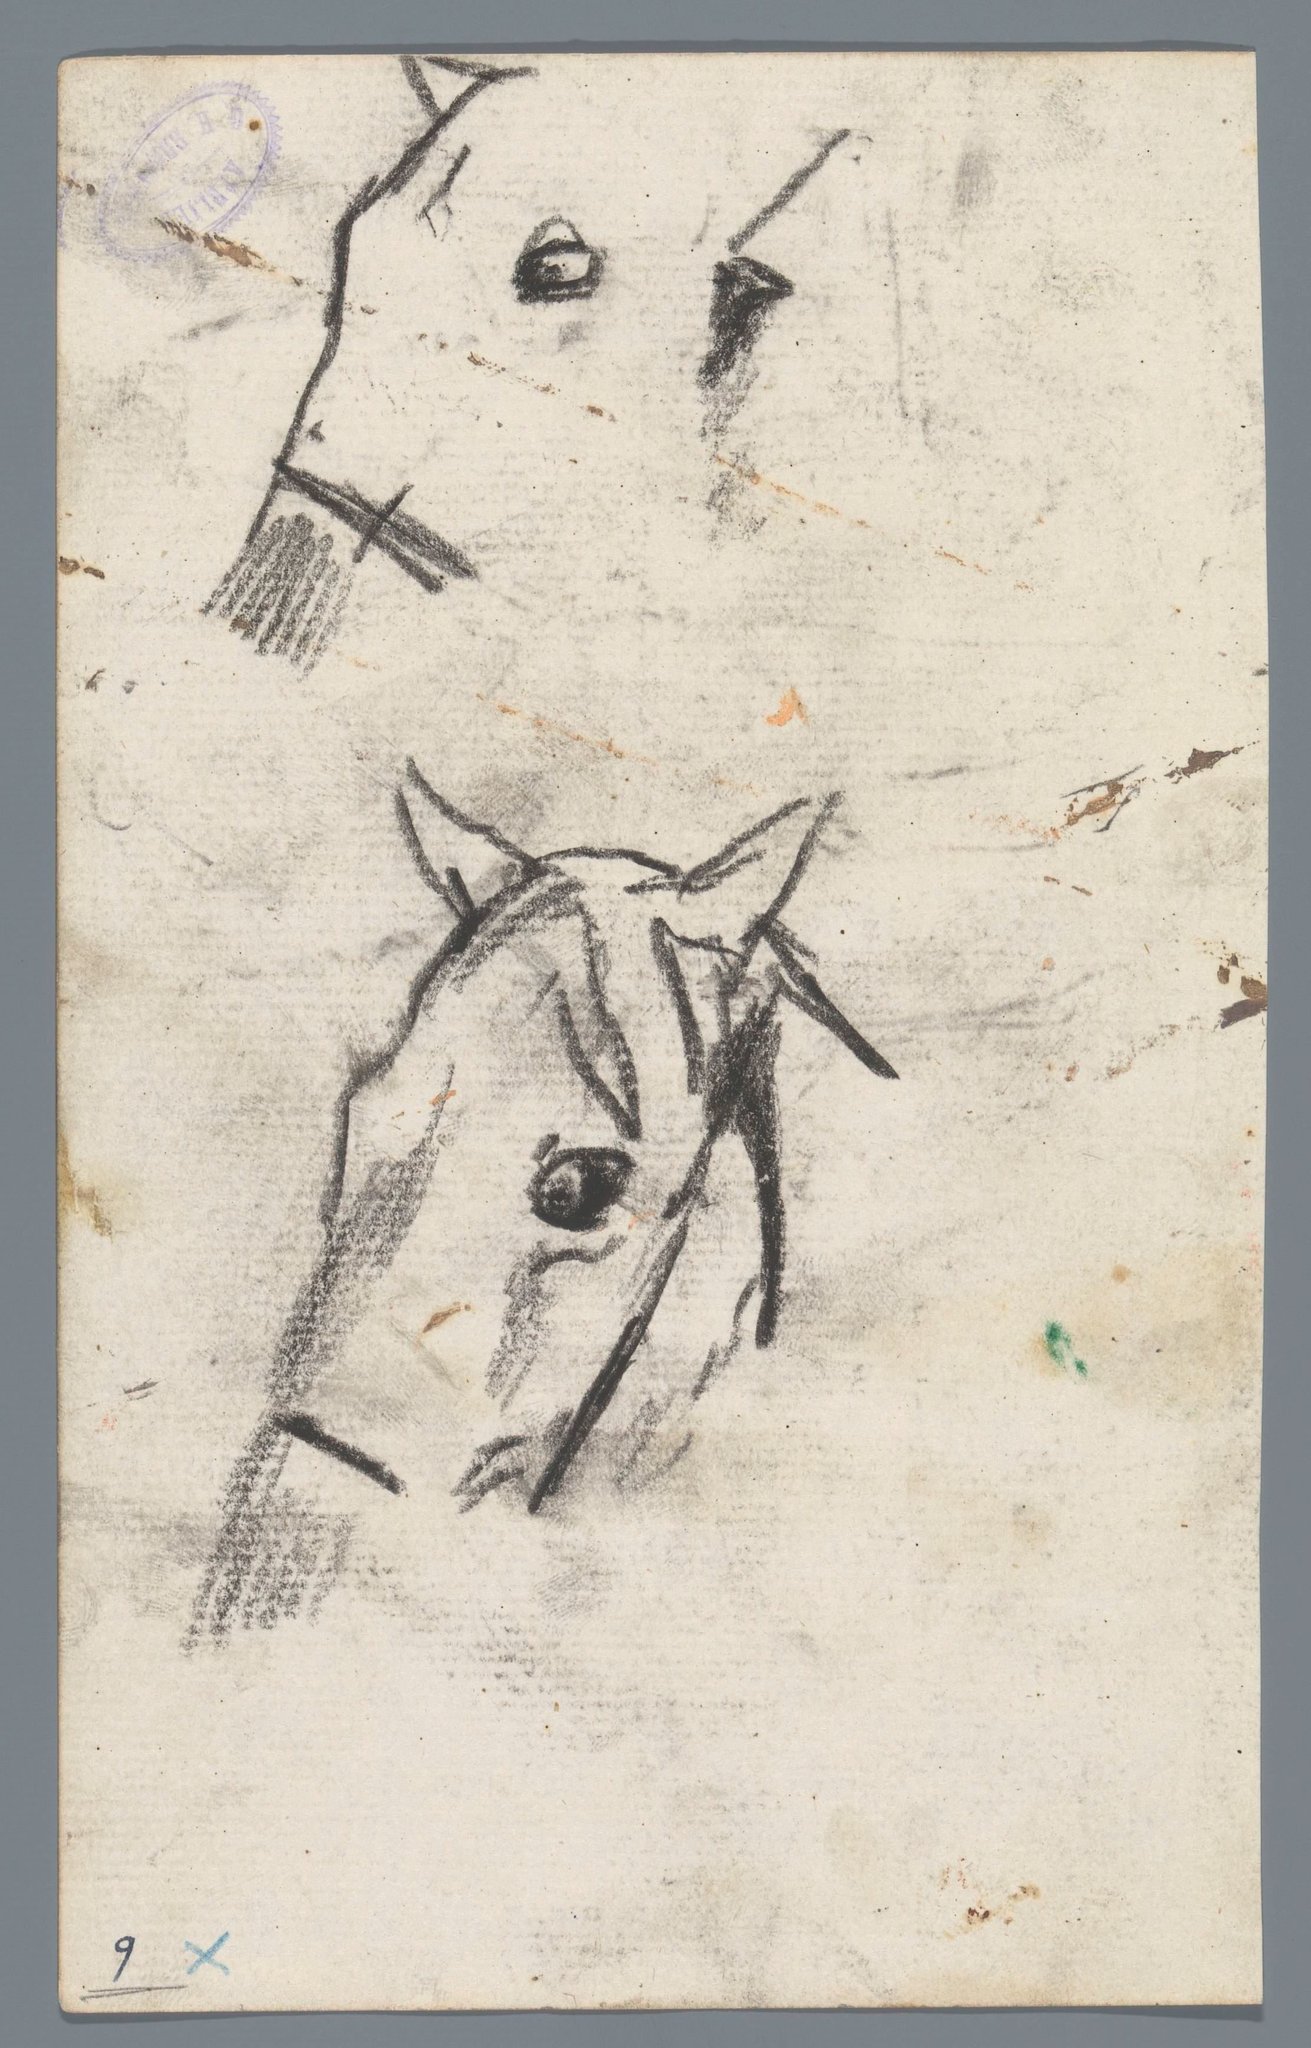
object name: drawing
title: Twee paardenhoofden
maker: george hendrik breitner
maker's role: draughtsman, painter, print maker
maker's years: 1857-1923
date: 1909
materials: chalk, paper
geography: amsterdam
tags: horse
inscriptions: workshop stamp: Lugt 291d